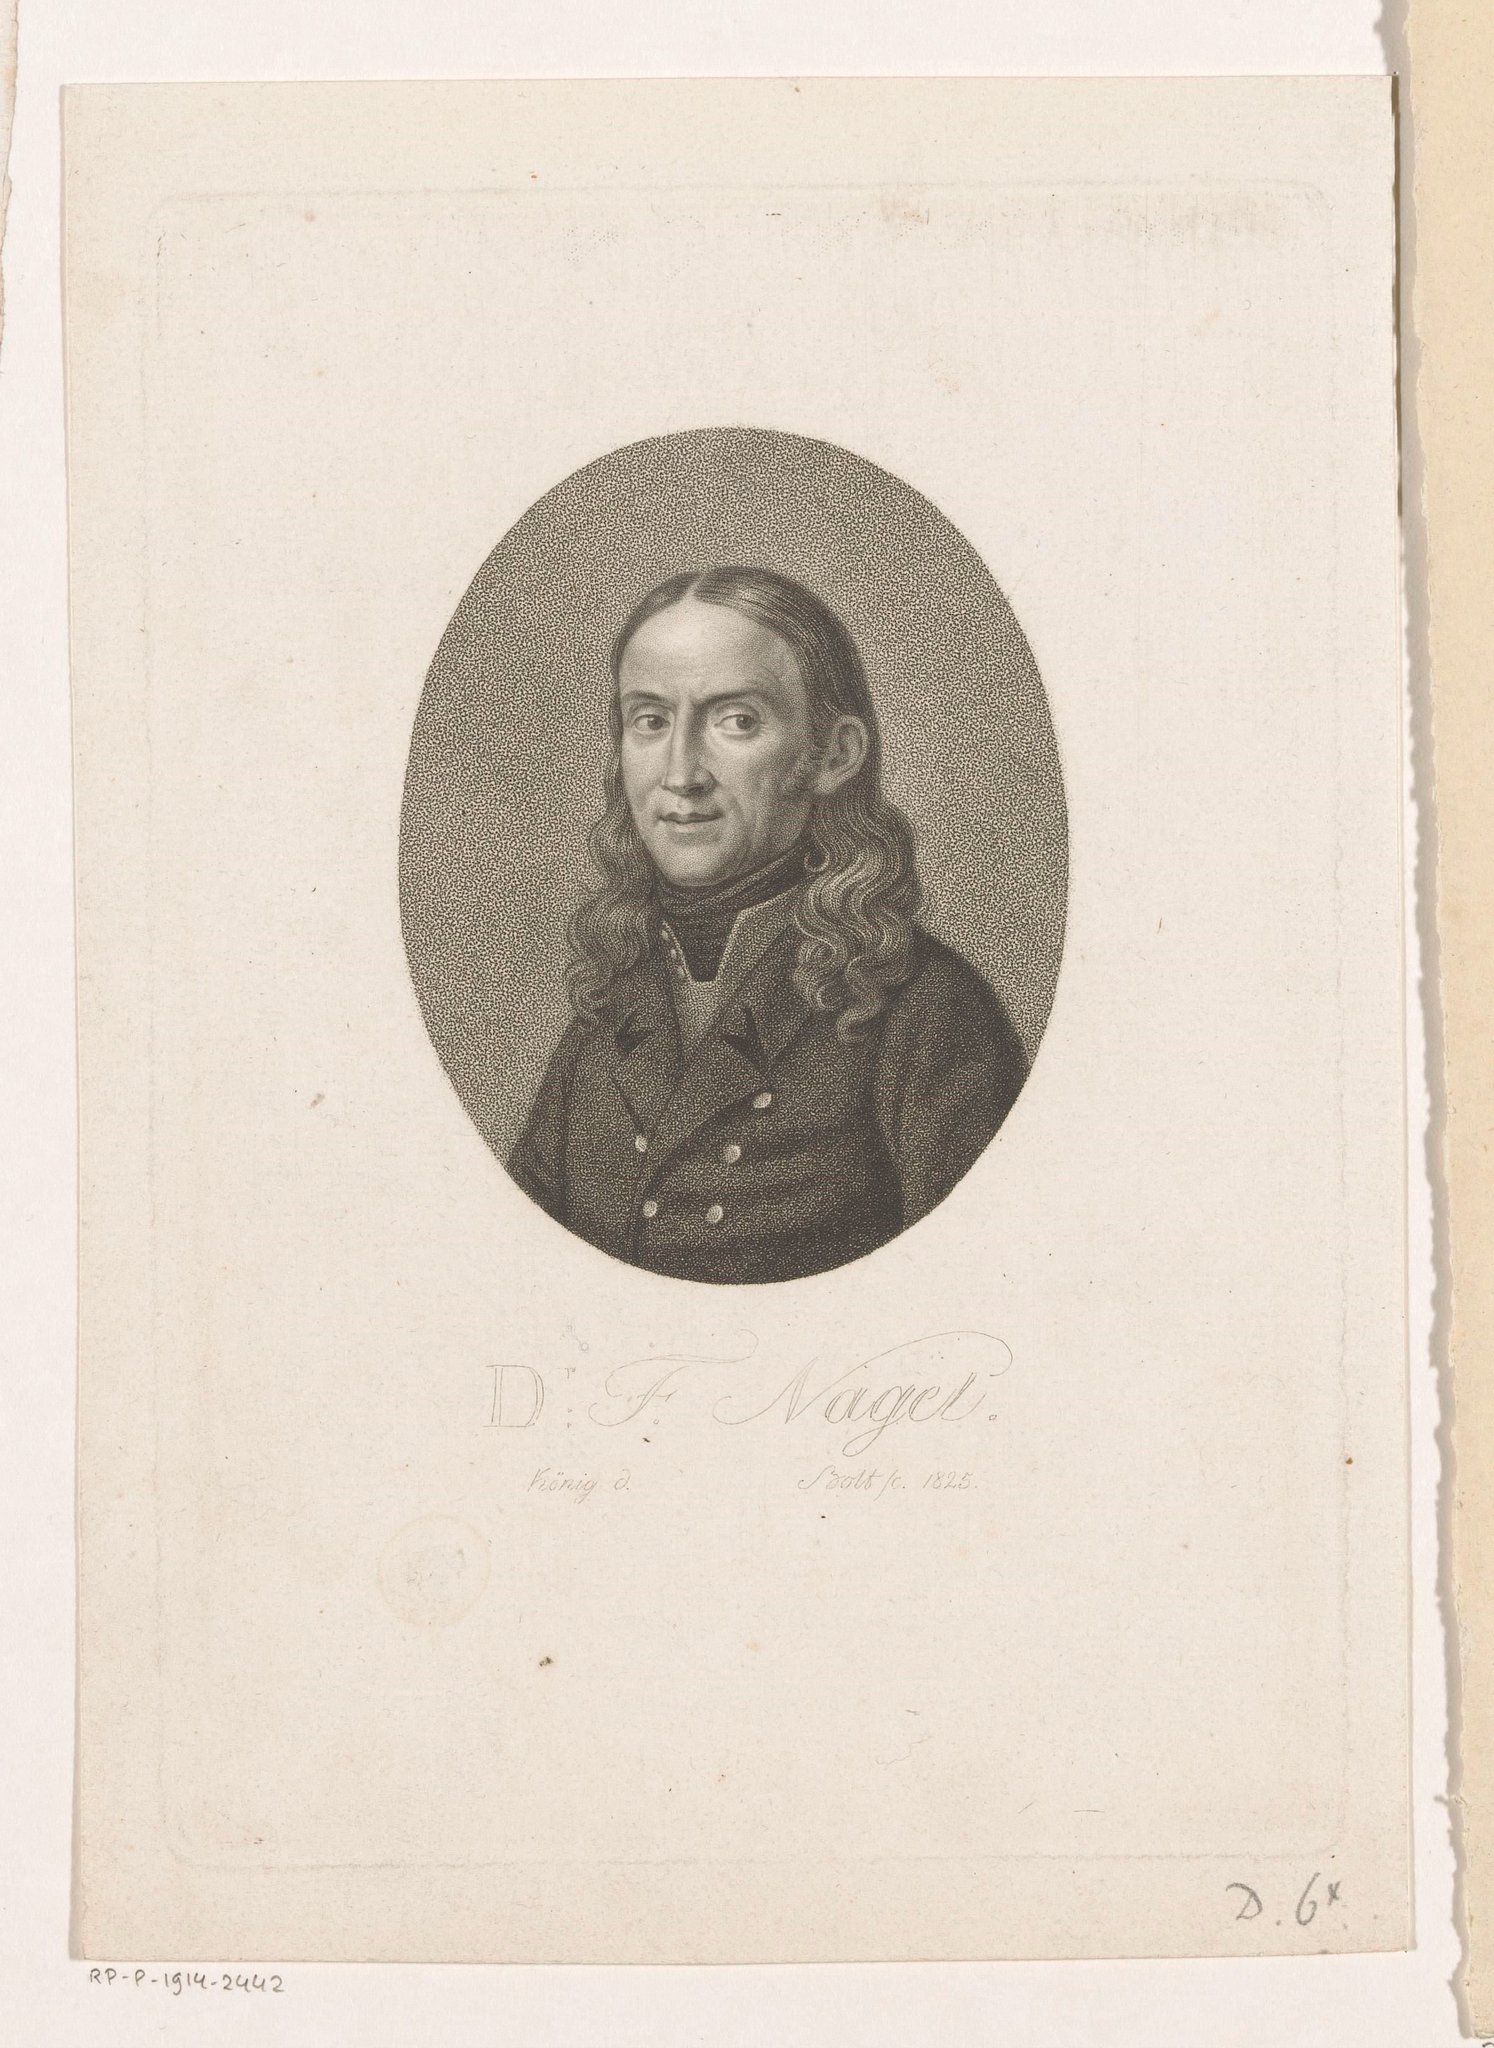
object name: print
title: Portret van Dr. F. Nagel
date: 1825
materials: paper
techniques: stippling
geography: berlin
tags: historical persons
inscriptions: collector's mark: Lugt 2228